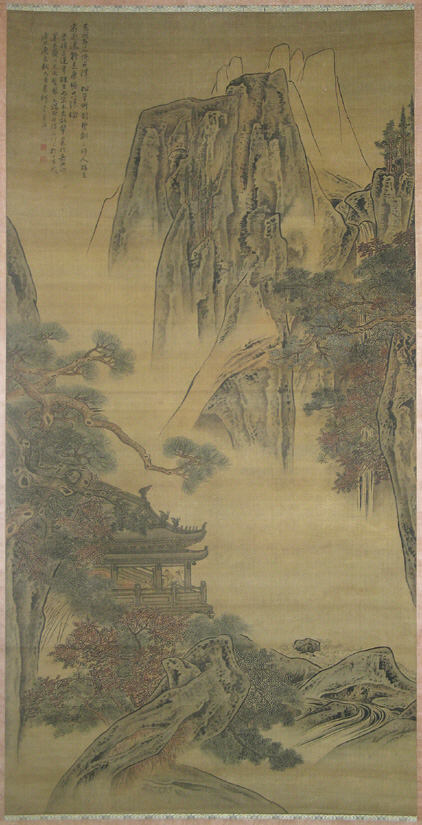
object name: hanging scroll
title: Viewing a waterfall from a mountain pavilion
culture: chinese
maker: li yin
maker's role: artist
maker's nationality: chinese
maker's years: 1650-1825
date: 1700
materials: ink, silk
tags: landscapes,trees